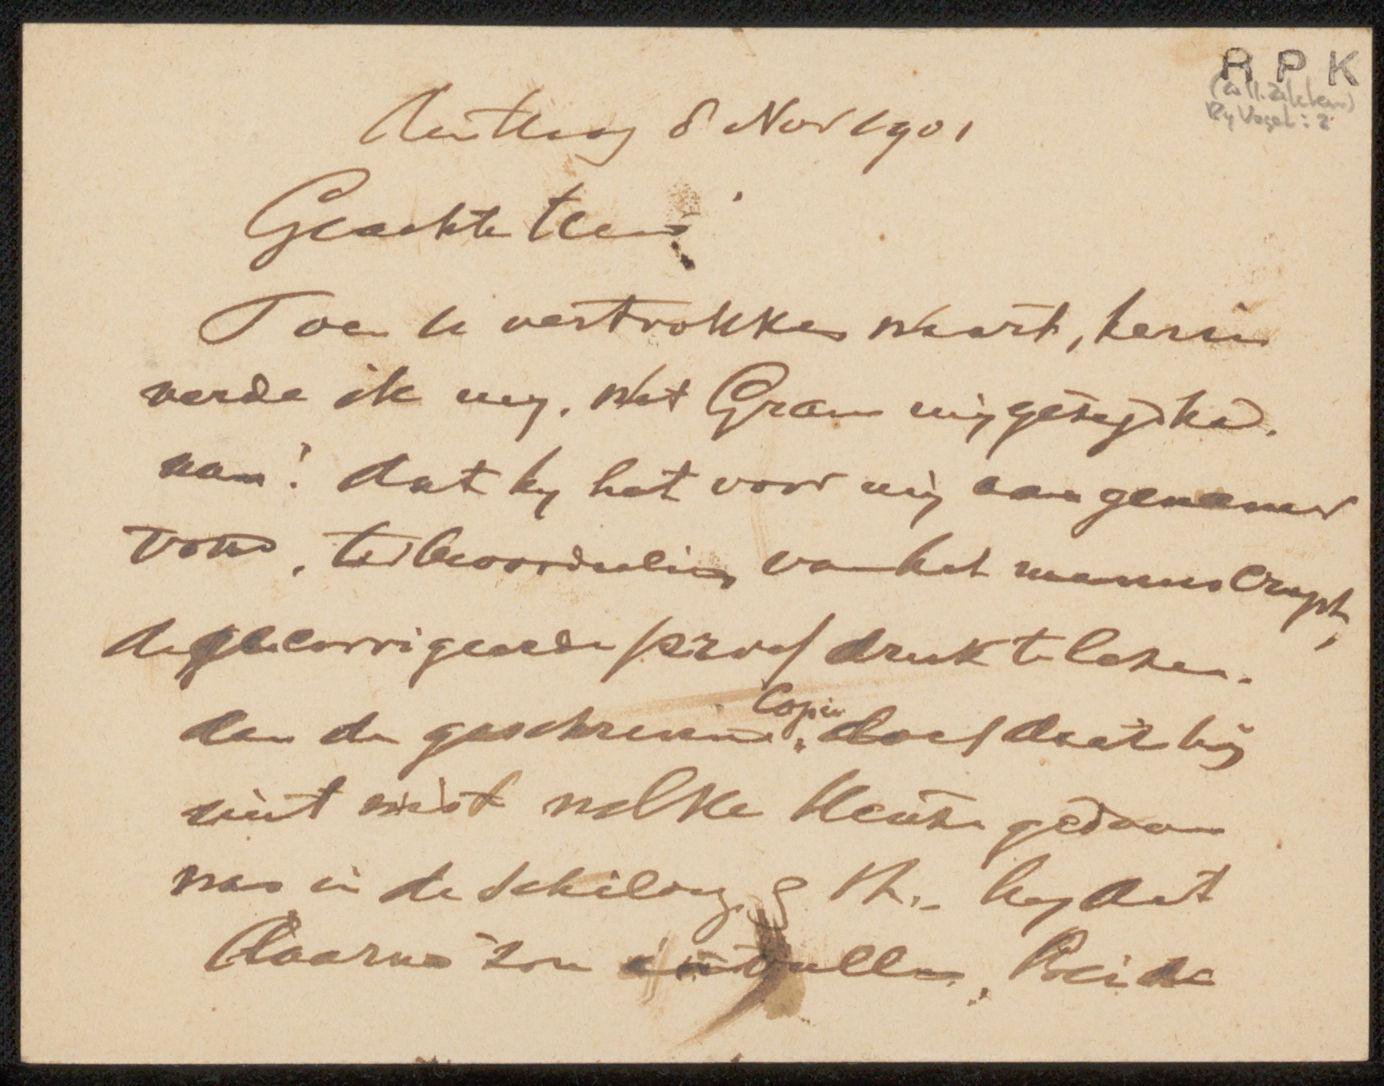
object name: letter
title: Brief aan Philip Zilcken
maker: margaretha roosenboom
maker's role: draughtsman, painter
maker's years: 1843-1896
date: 1901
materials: cardboard, ink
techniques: pen, writing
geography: the hague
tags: johan gram, philip zilcken, printed matter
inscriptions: collector's mark: ‘RPK’